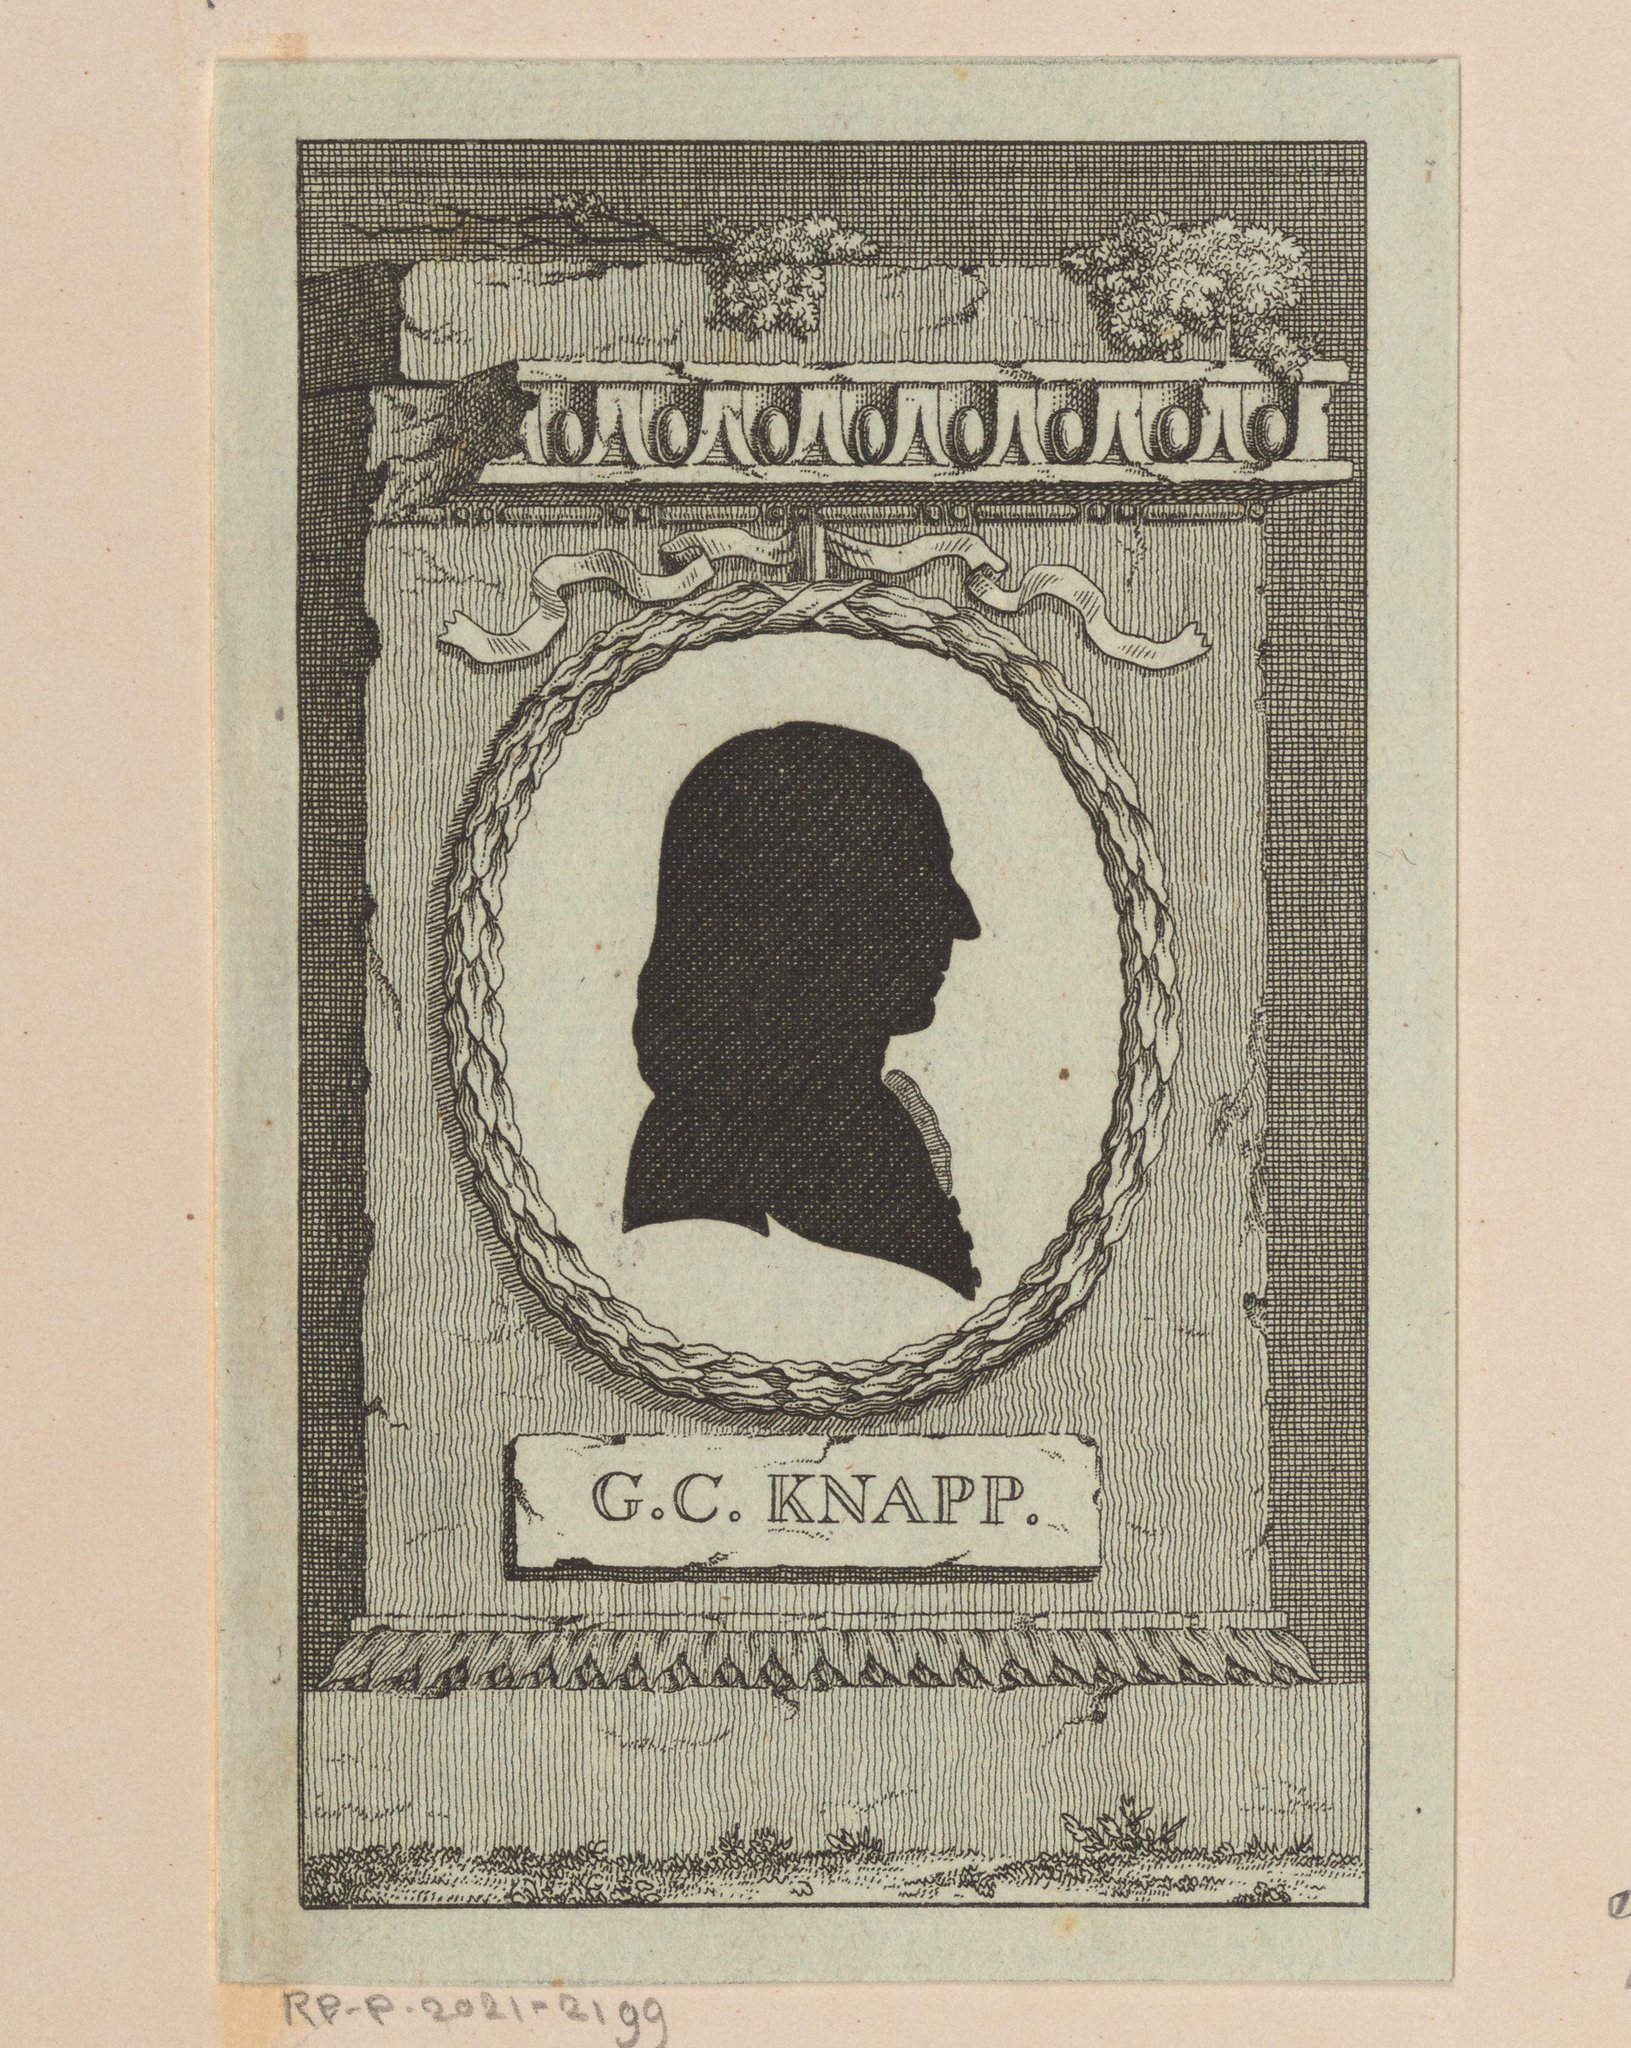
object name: print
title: Silhouetportret van Georg Christian Knapp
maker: Anonymous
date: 1793-1899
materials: paper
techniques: etching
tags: historical persons, grave, tomb